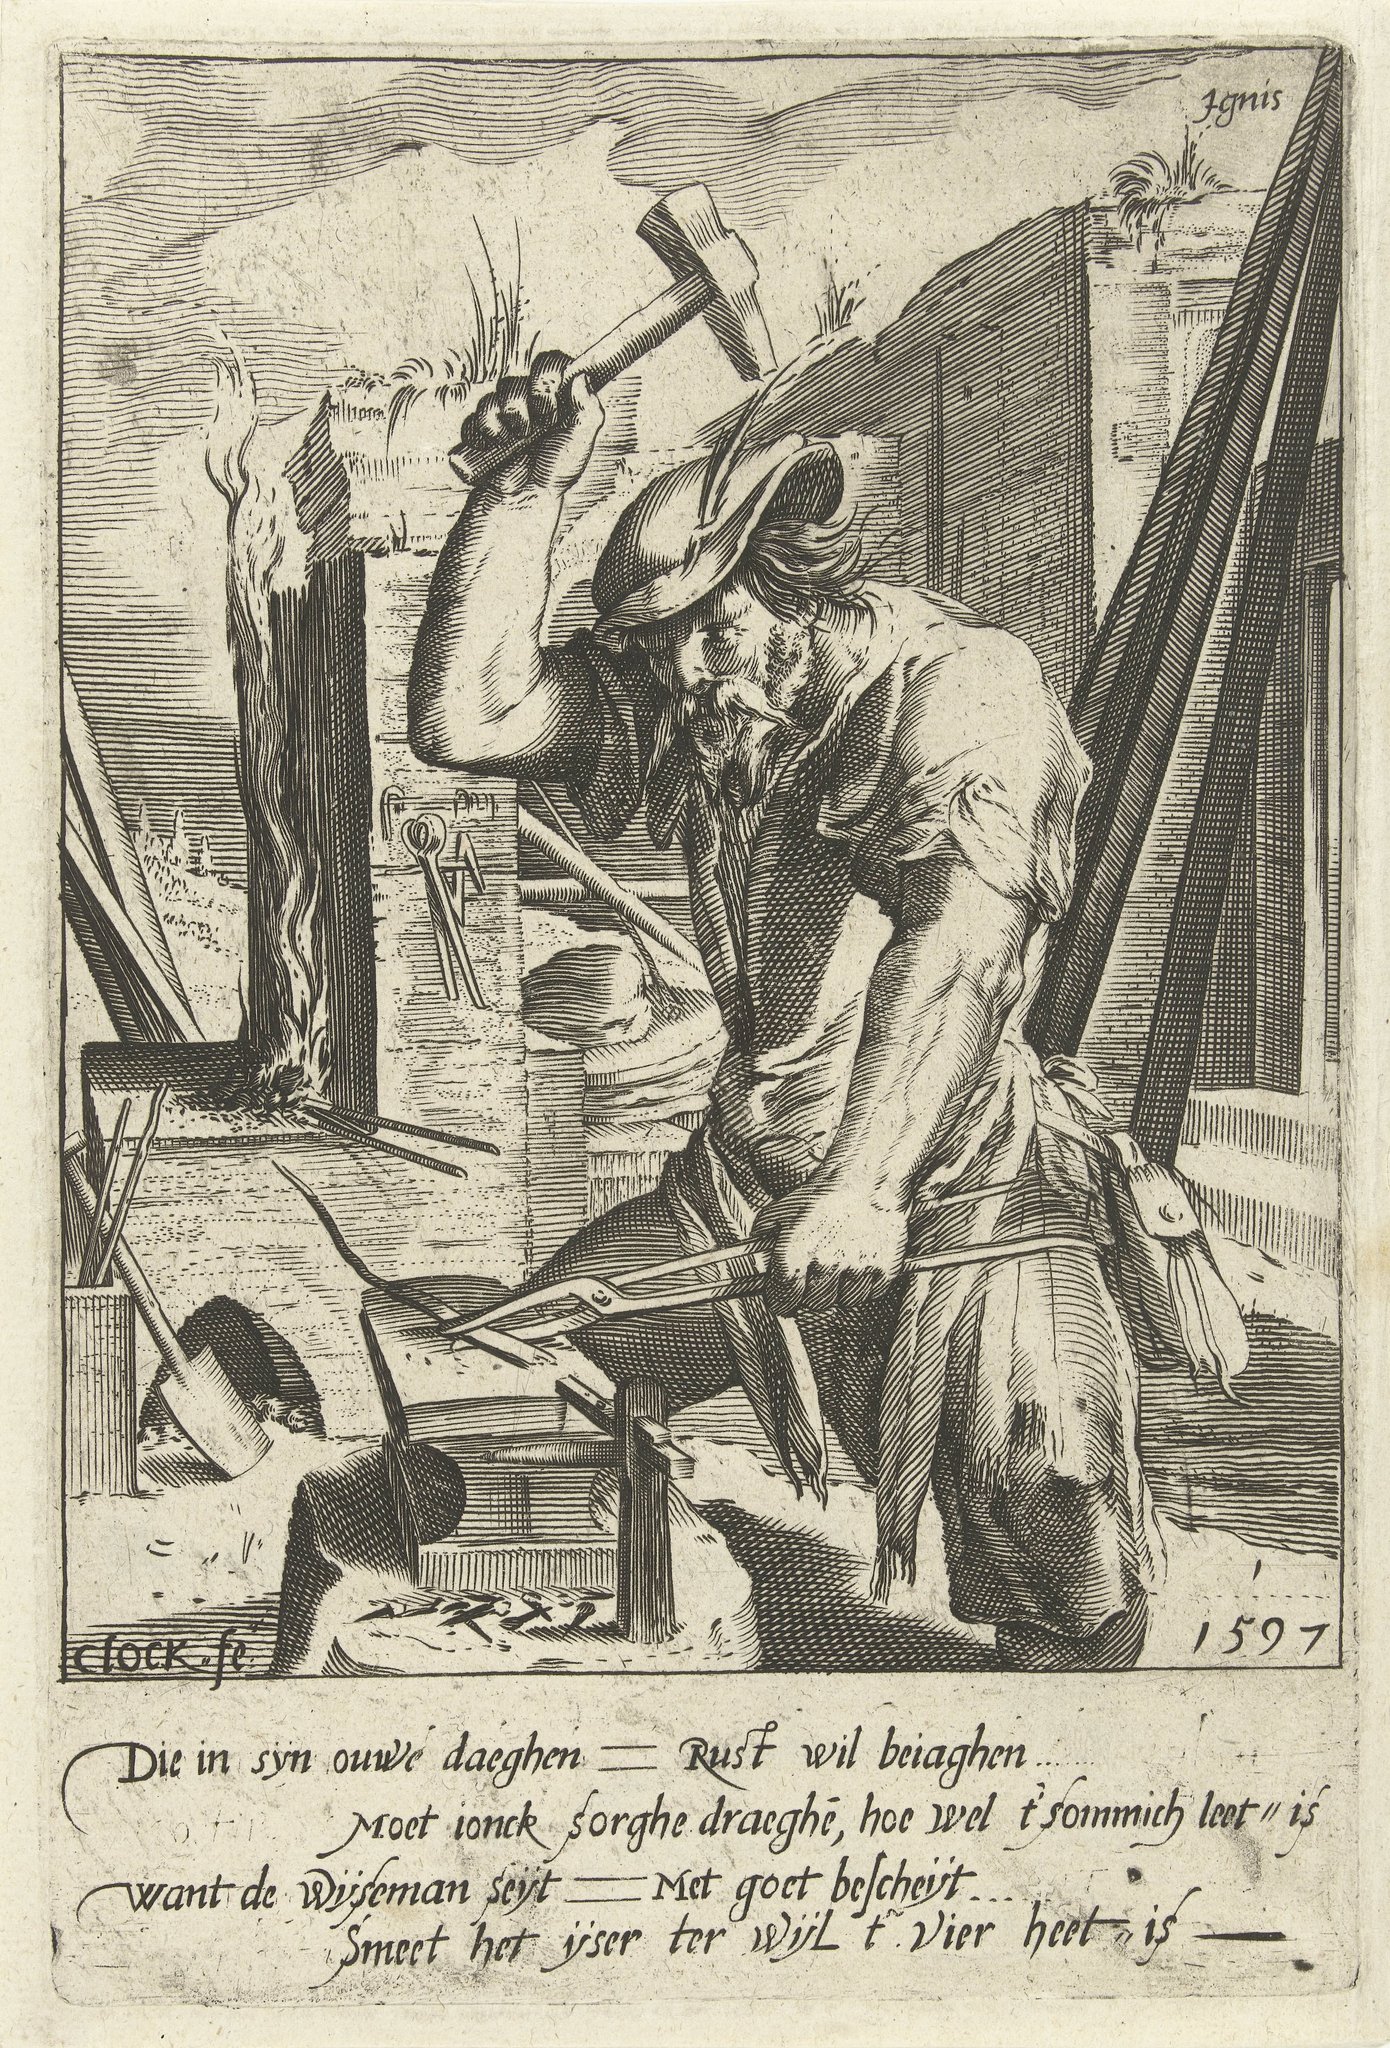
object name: print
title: Ignis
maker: nicolaes jansz. clock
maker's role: print maker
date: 1597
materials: paper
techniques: engraving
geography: haarlem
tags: fire (one of the four elements), fire, oven, furnace ~ interior of industrial structure, smith, blacksmith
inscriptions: collector's mark: Lugt 2228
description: Een smid aan het werk in zijn smidse. Hij slaat met zijn hamer op een aambeeld. De smid staat symbool voor het element vuur. De prent heeft een Nederlands onderschrift dat de ambachtsman prijst voor zijn arbeidsijver. De prent is deel van een vierdelige serie over de vier elementen.